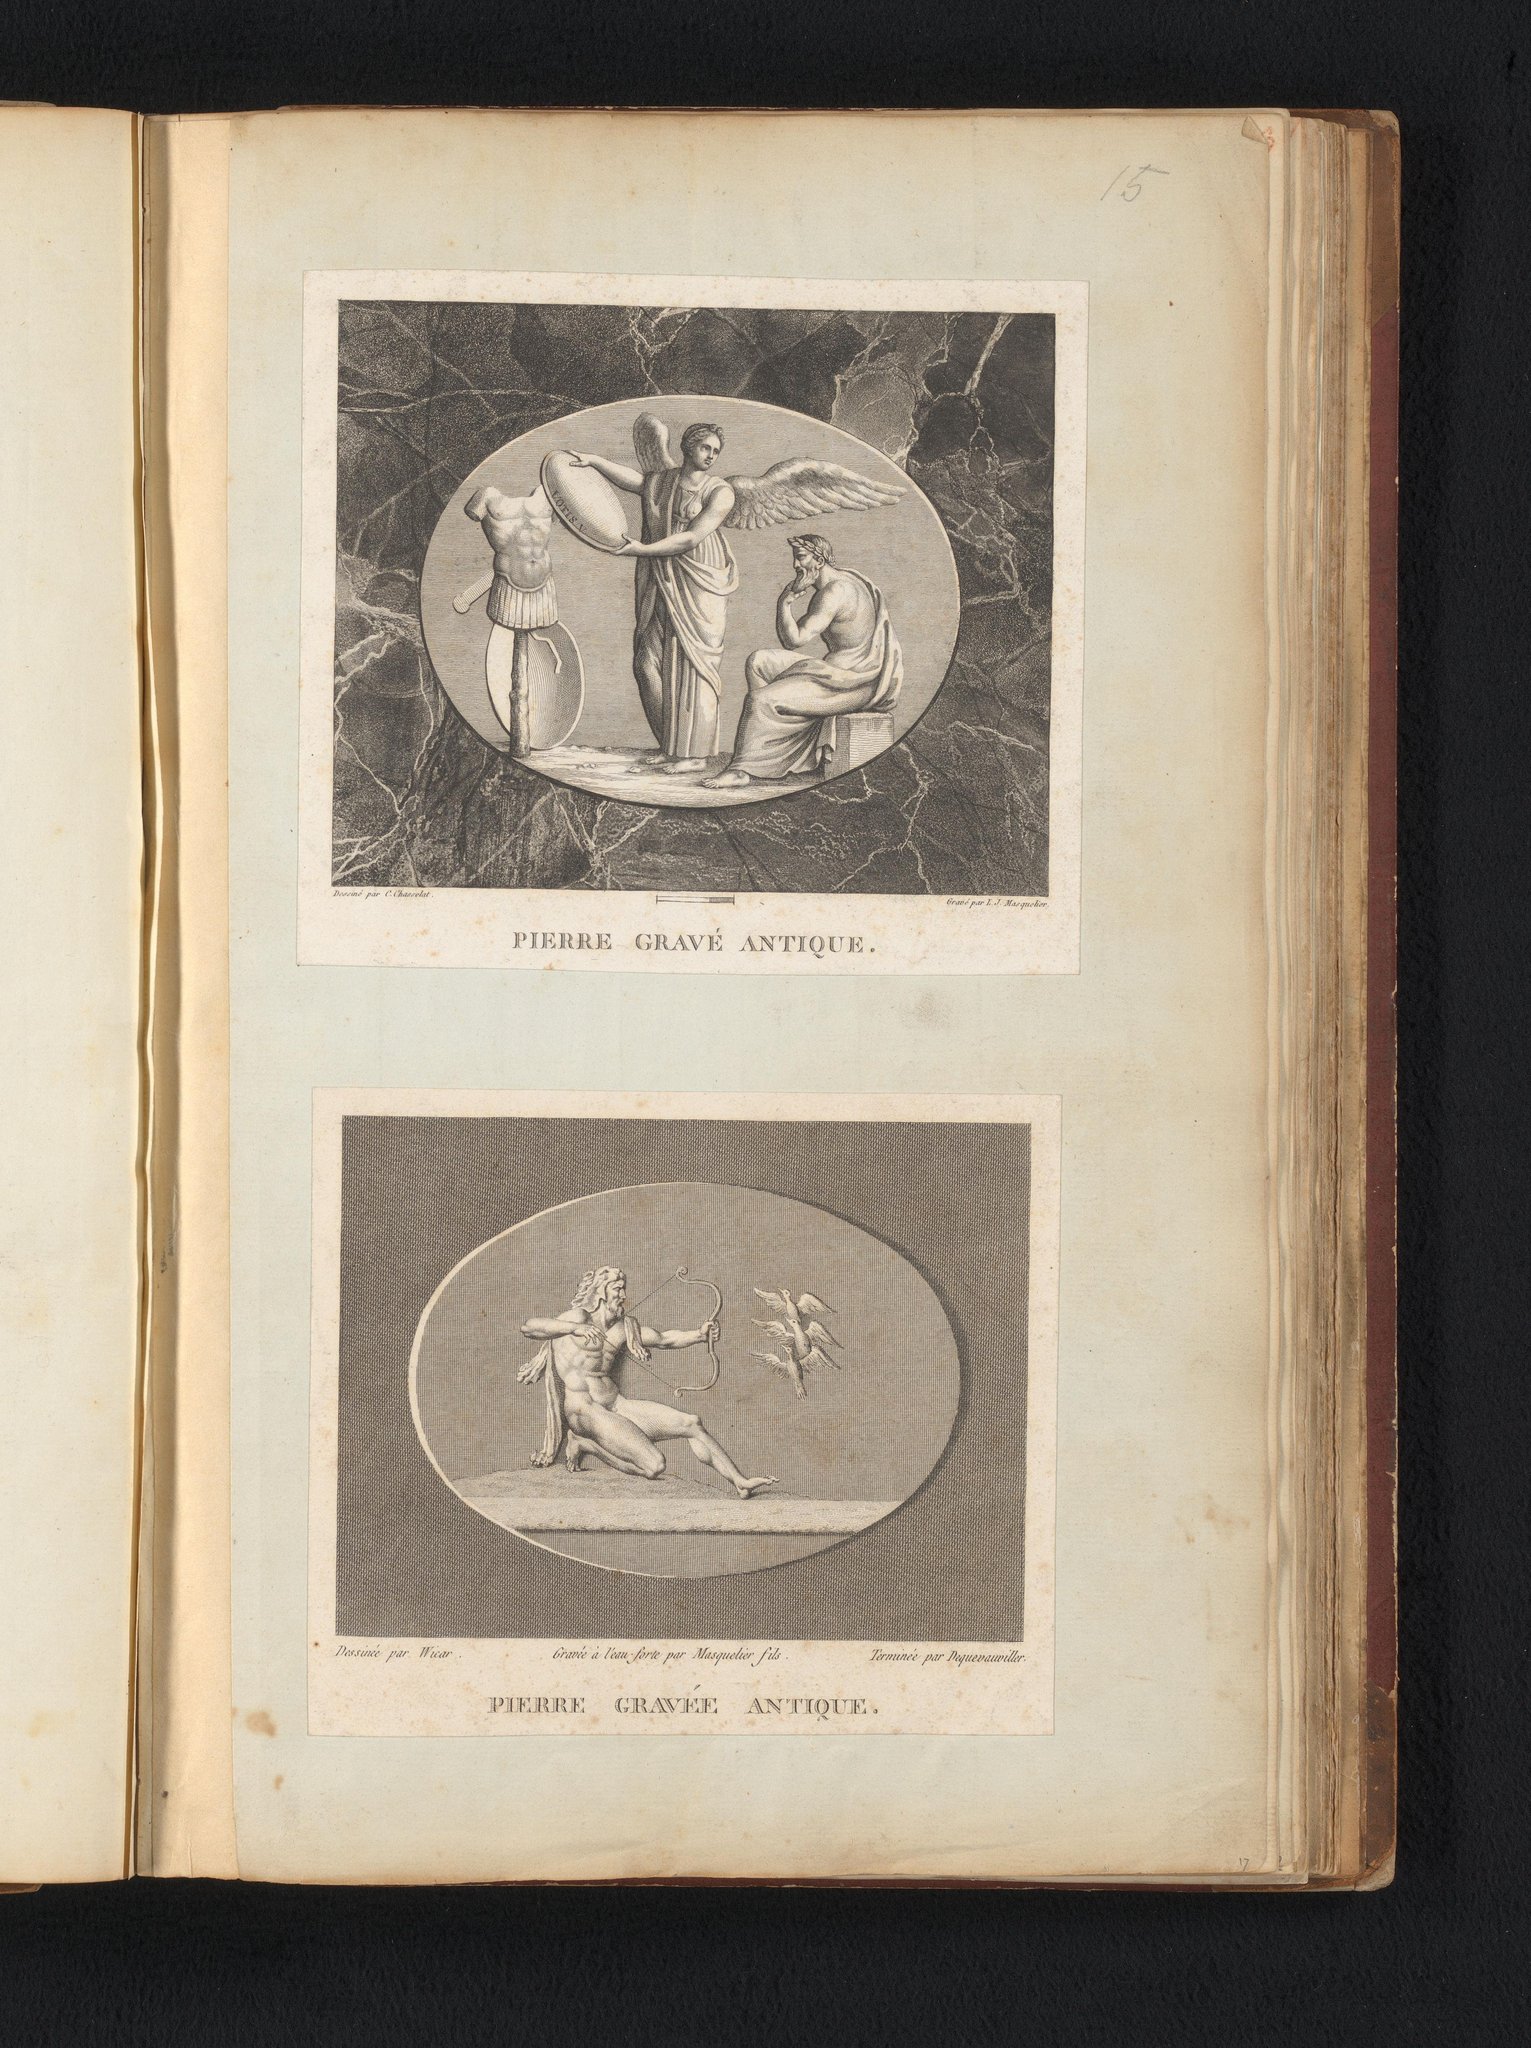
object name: album leaf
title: Antieke cameeën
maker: louis joseph masquelier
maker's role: print maker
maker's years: 1741-1811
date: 1750-1816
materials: paper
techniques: engraving, etching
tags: carving ~ applied arts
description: Twee antieke cameeën. Onderdeel van het tweede van twee albums met ingeplakte prenten en tekeningen te dienen als tekenvoorbeelden.